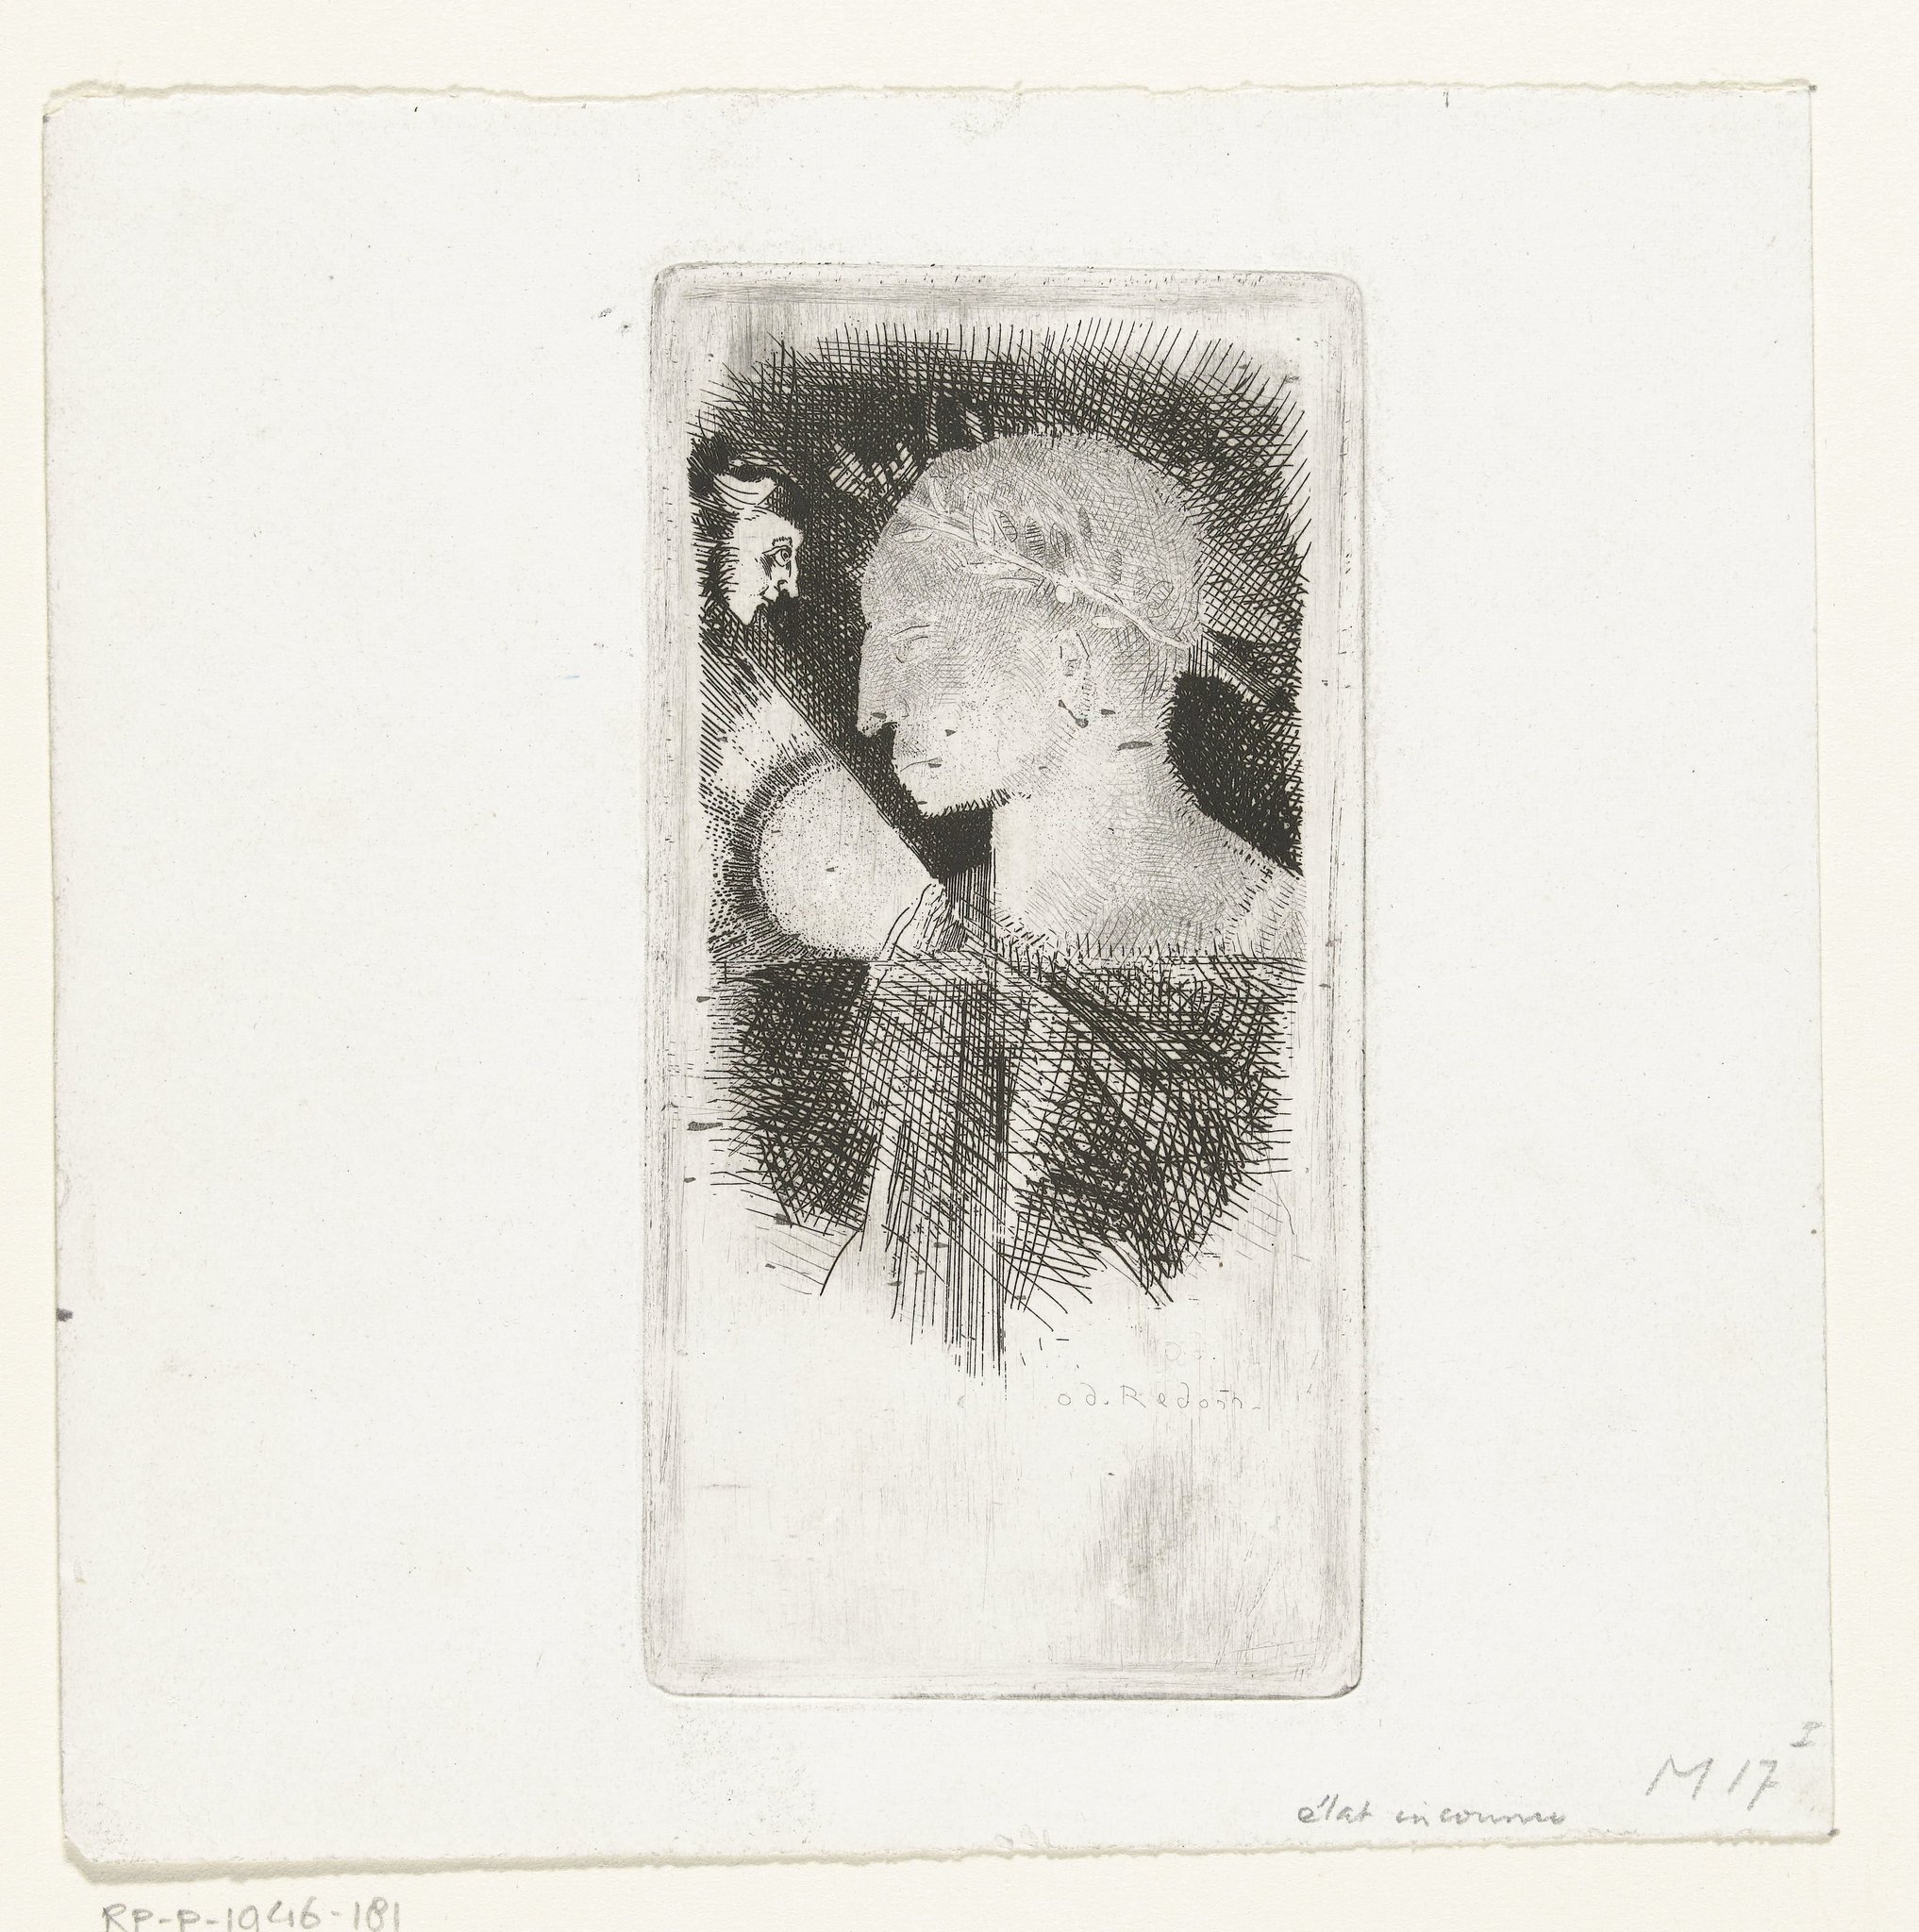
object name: print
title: Mauvaise gloire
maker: odilon redon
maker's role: draughtsman, painter, print maker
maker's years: 1840-1916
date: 1886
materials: paper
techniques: drypoint, etching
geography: france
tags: classical history (+ (full) bust), crowning with laurel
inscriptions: collector's mark: Lugt 2760, collector's mark: Lugt 2228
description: Buste van een man met een lauwerkrans, een tweede hoofd linksboven.